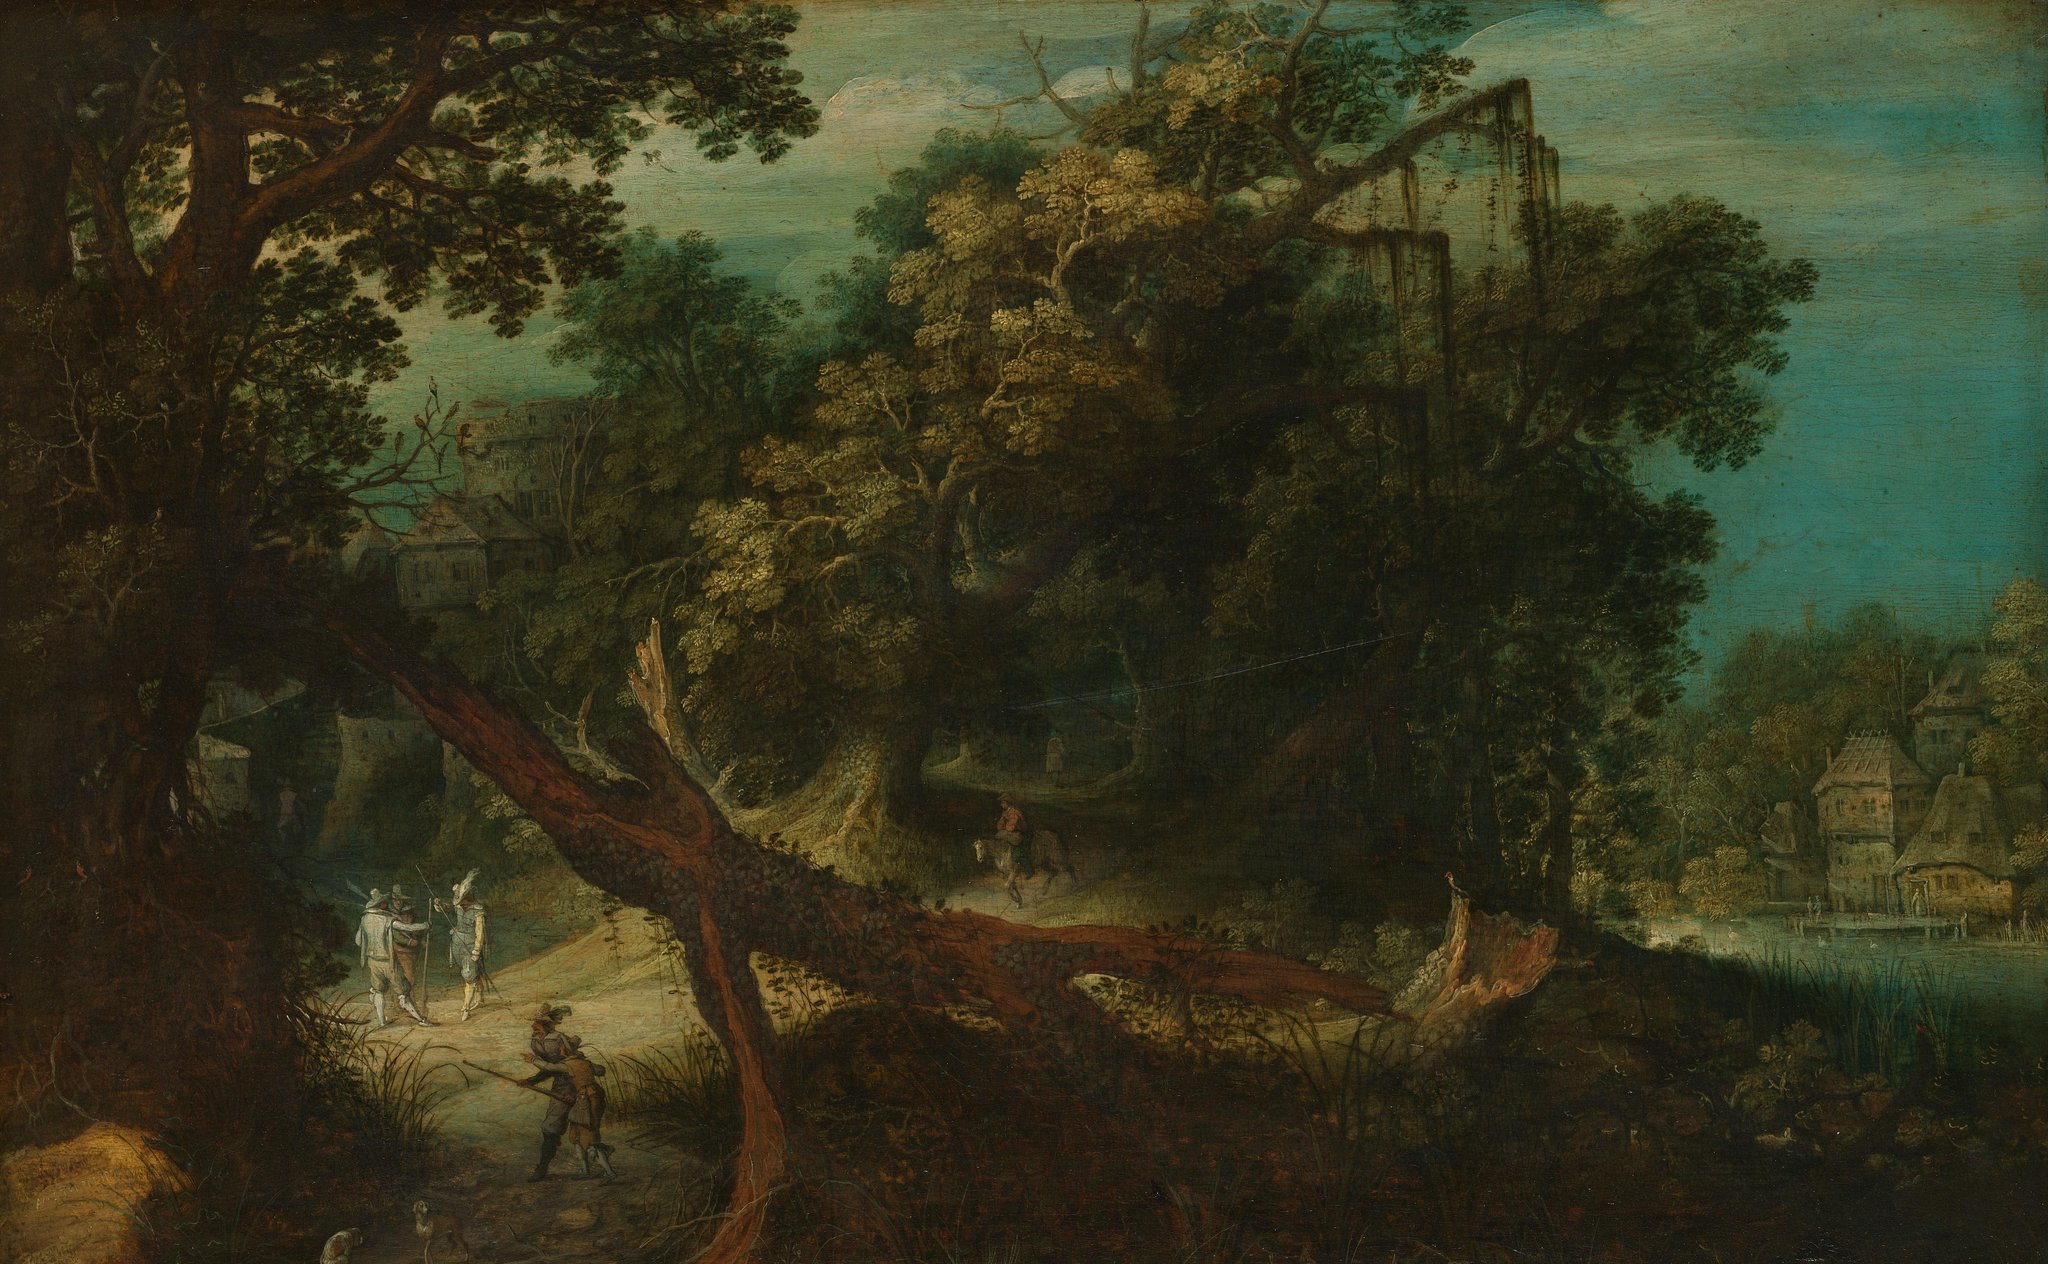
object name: painting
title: Shooters in a Forest Glade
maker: adriaen van stalbemt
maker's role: painter, print maker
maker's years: 1580-1662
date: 1620-1661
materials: oil, panel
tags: hunter, forest, wood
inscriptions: signature, bottom left: ‘AV [linked]·STALBEMPT’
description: Bergachtig landschap met een groep jagers met honden in een bos. Tussen de bomen links zitten huizen verscholen, rechts een rivier met huizen.